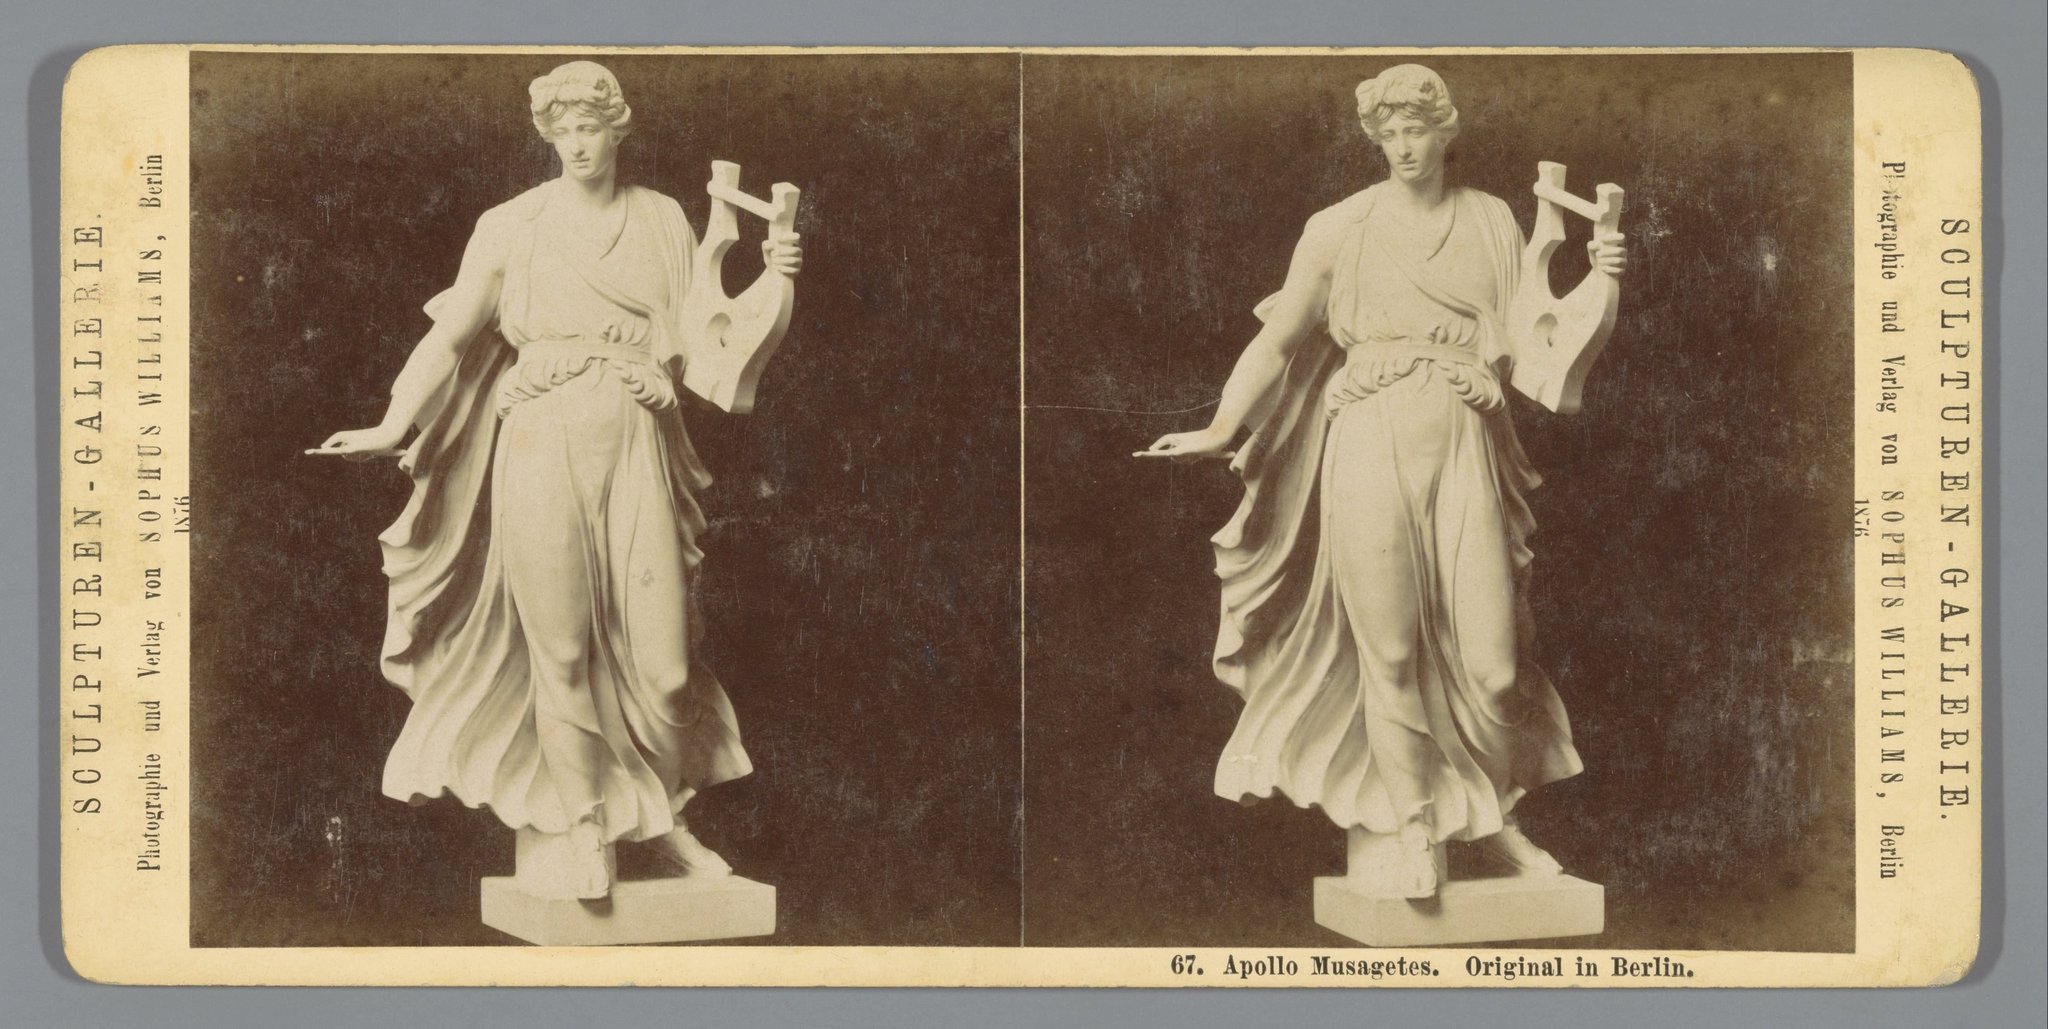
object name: stereograph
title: Sculptuur van Apollo Musagetes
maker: sophus williams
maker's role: publisher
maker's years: 1835-1900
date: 1876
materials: cardboard, photographic support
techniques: albumen print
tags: apollo and the muses, apollo musagetes, (story of) apollo (phoebus)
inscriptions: number: ‘67’, : ‘Berlin’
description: Sculptuur van de god van de muziek, Apollo.